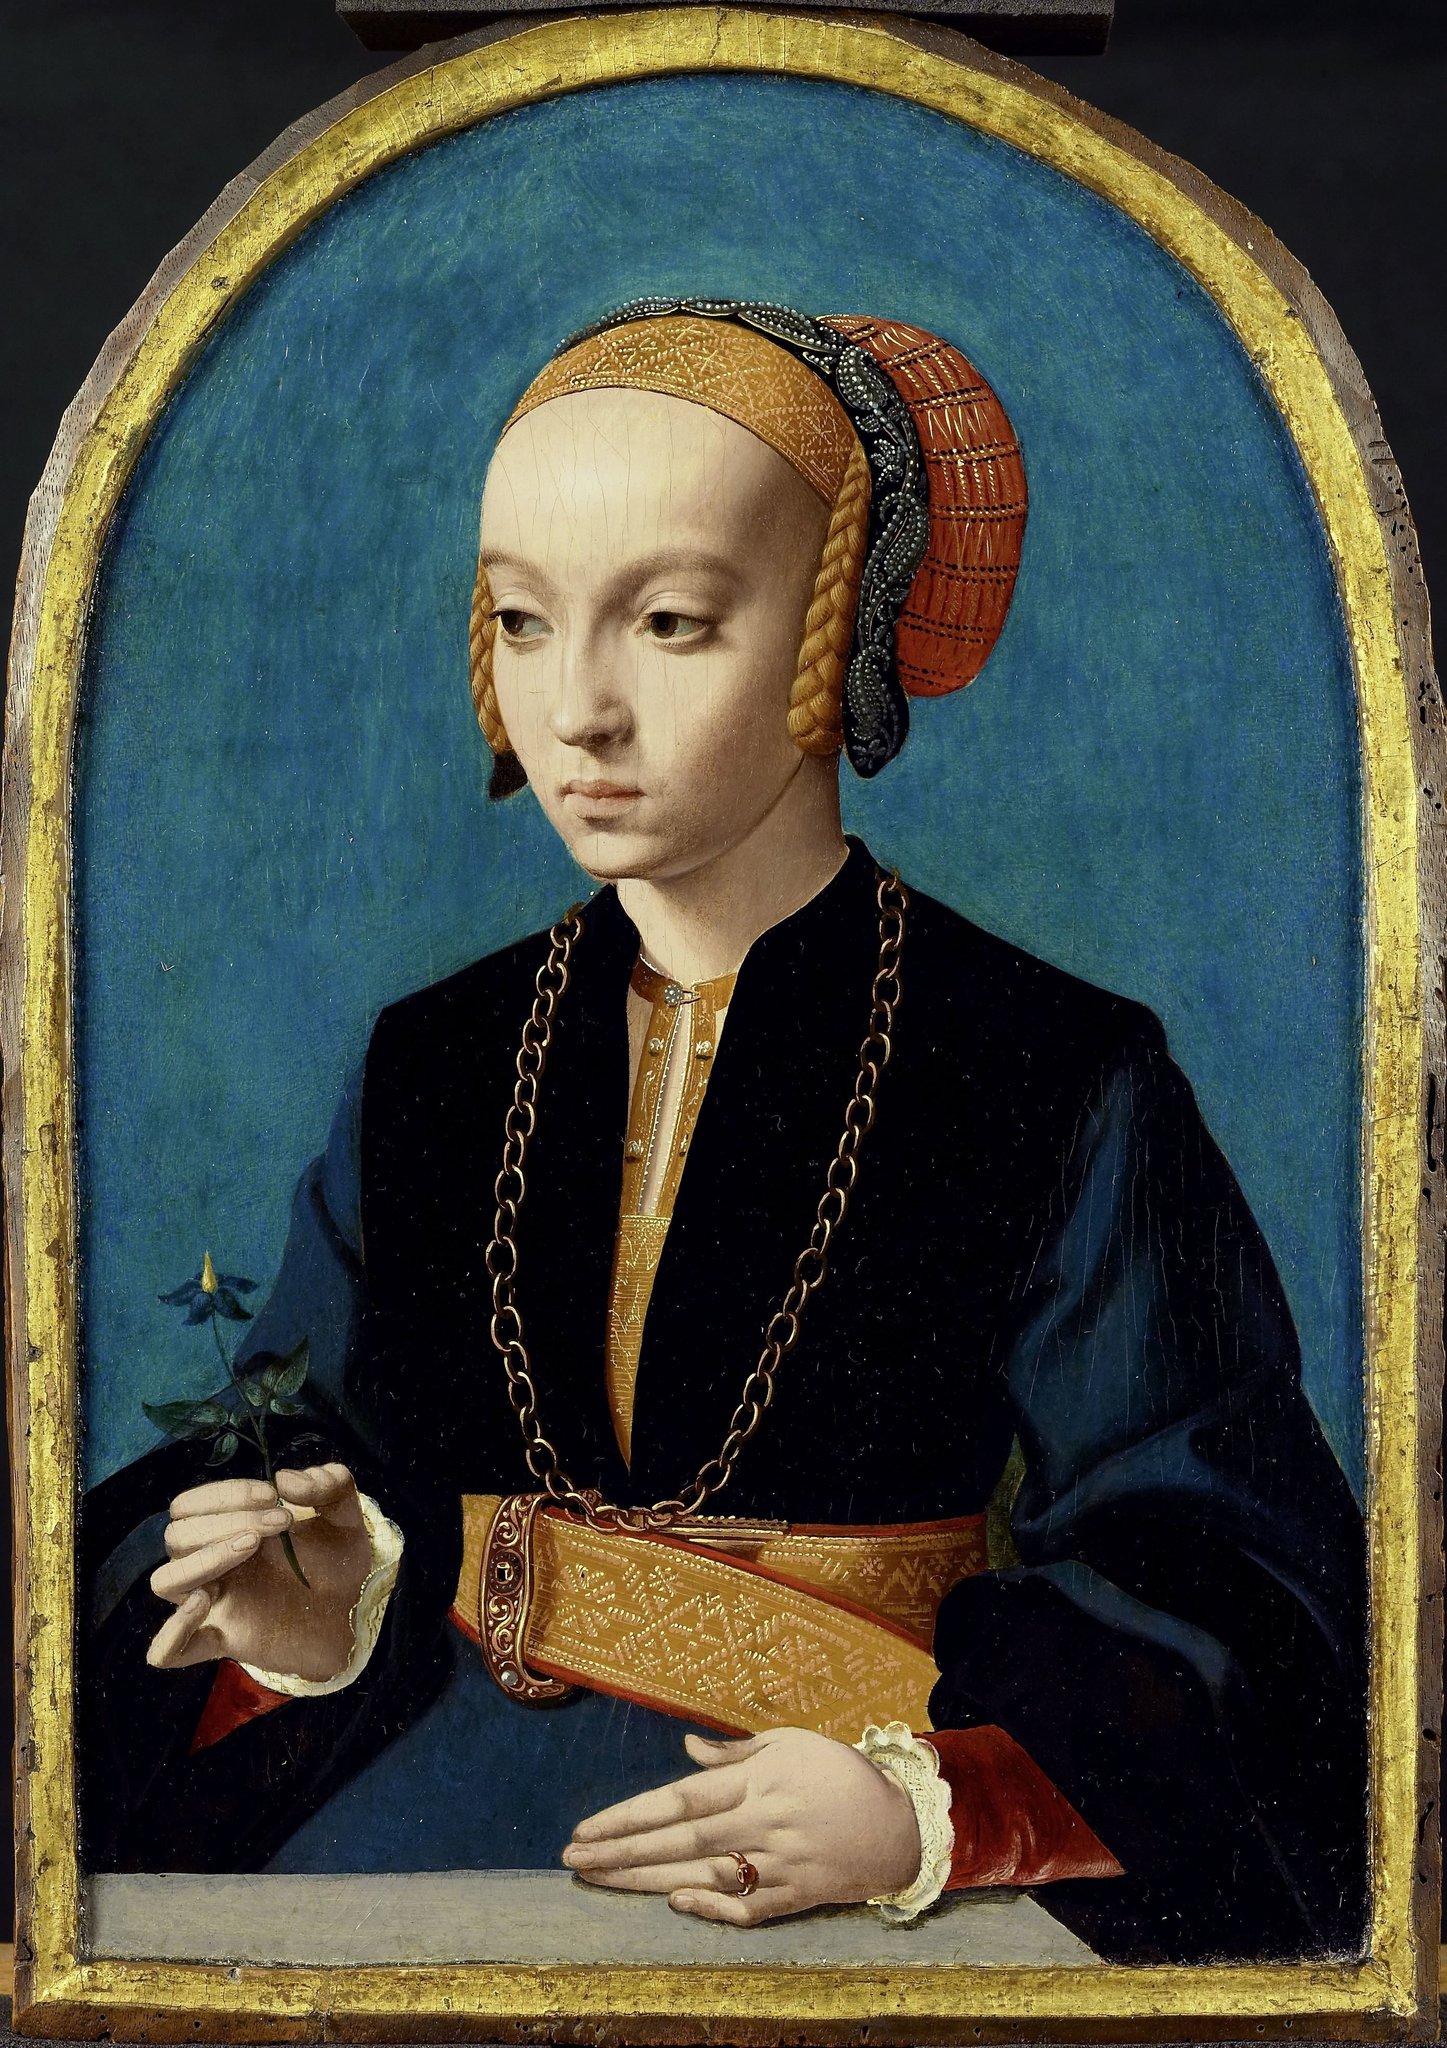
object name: painting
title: Portrait of Elisabeth Bellinghausen (c.1520- after 1570)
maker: bartholomäus bruyn (i)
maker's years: 1493-1555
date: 1538-1539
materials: oil, panel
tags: cologne, historical persons - bb - woman, flowers: bittersweet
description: Portret van Elisabeth Bellinghausen. Portret van de jonge vrouw, ten halven lijve, zittend achter een balustrade, in de rechterhand een takje bitterzoet. Om de hals een gouden ketting, om de middel een brede ceintuur met een gouden gesp. Zij draagt een met parels bestikt mutsje op het hoofd. De geportretteerde is een dochter van prof. Peter Bellinghausen, kanselier van Keulen. Het schilderij is een pendant van het portret van Jacobus Omphalius (1500-1567) in het Mauritshuis, Den Haag (inv.nr. 1225).